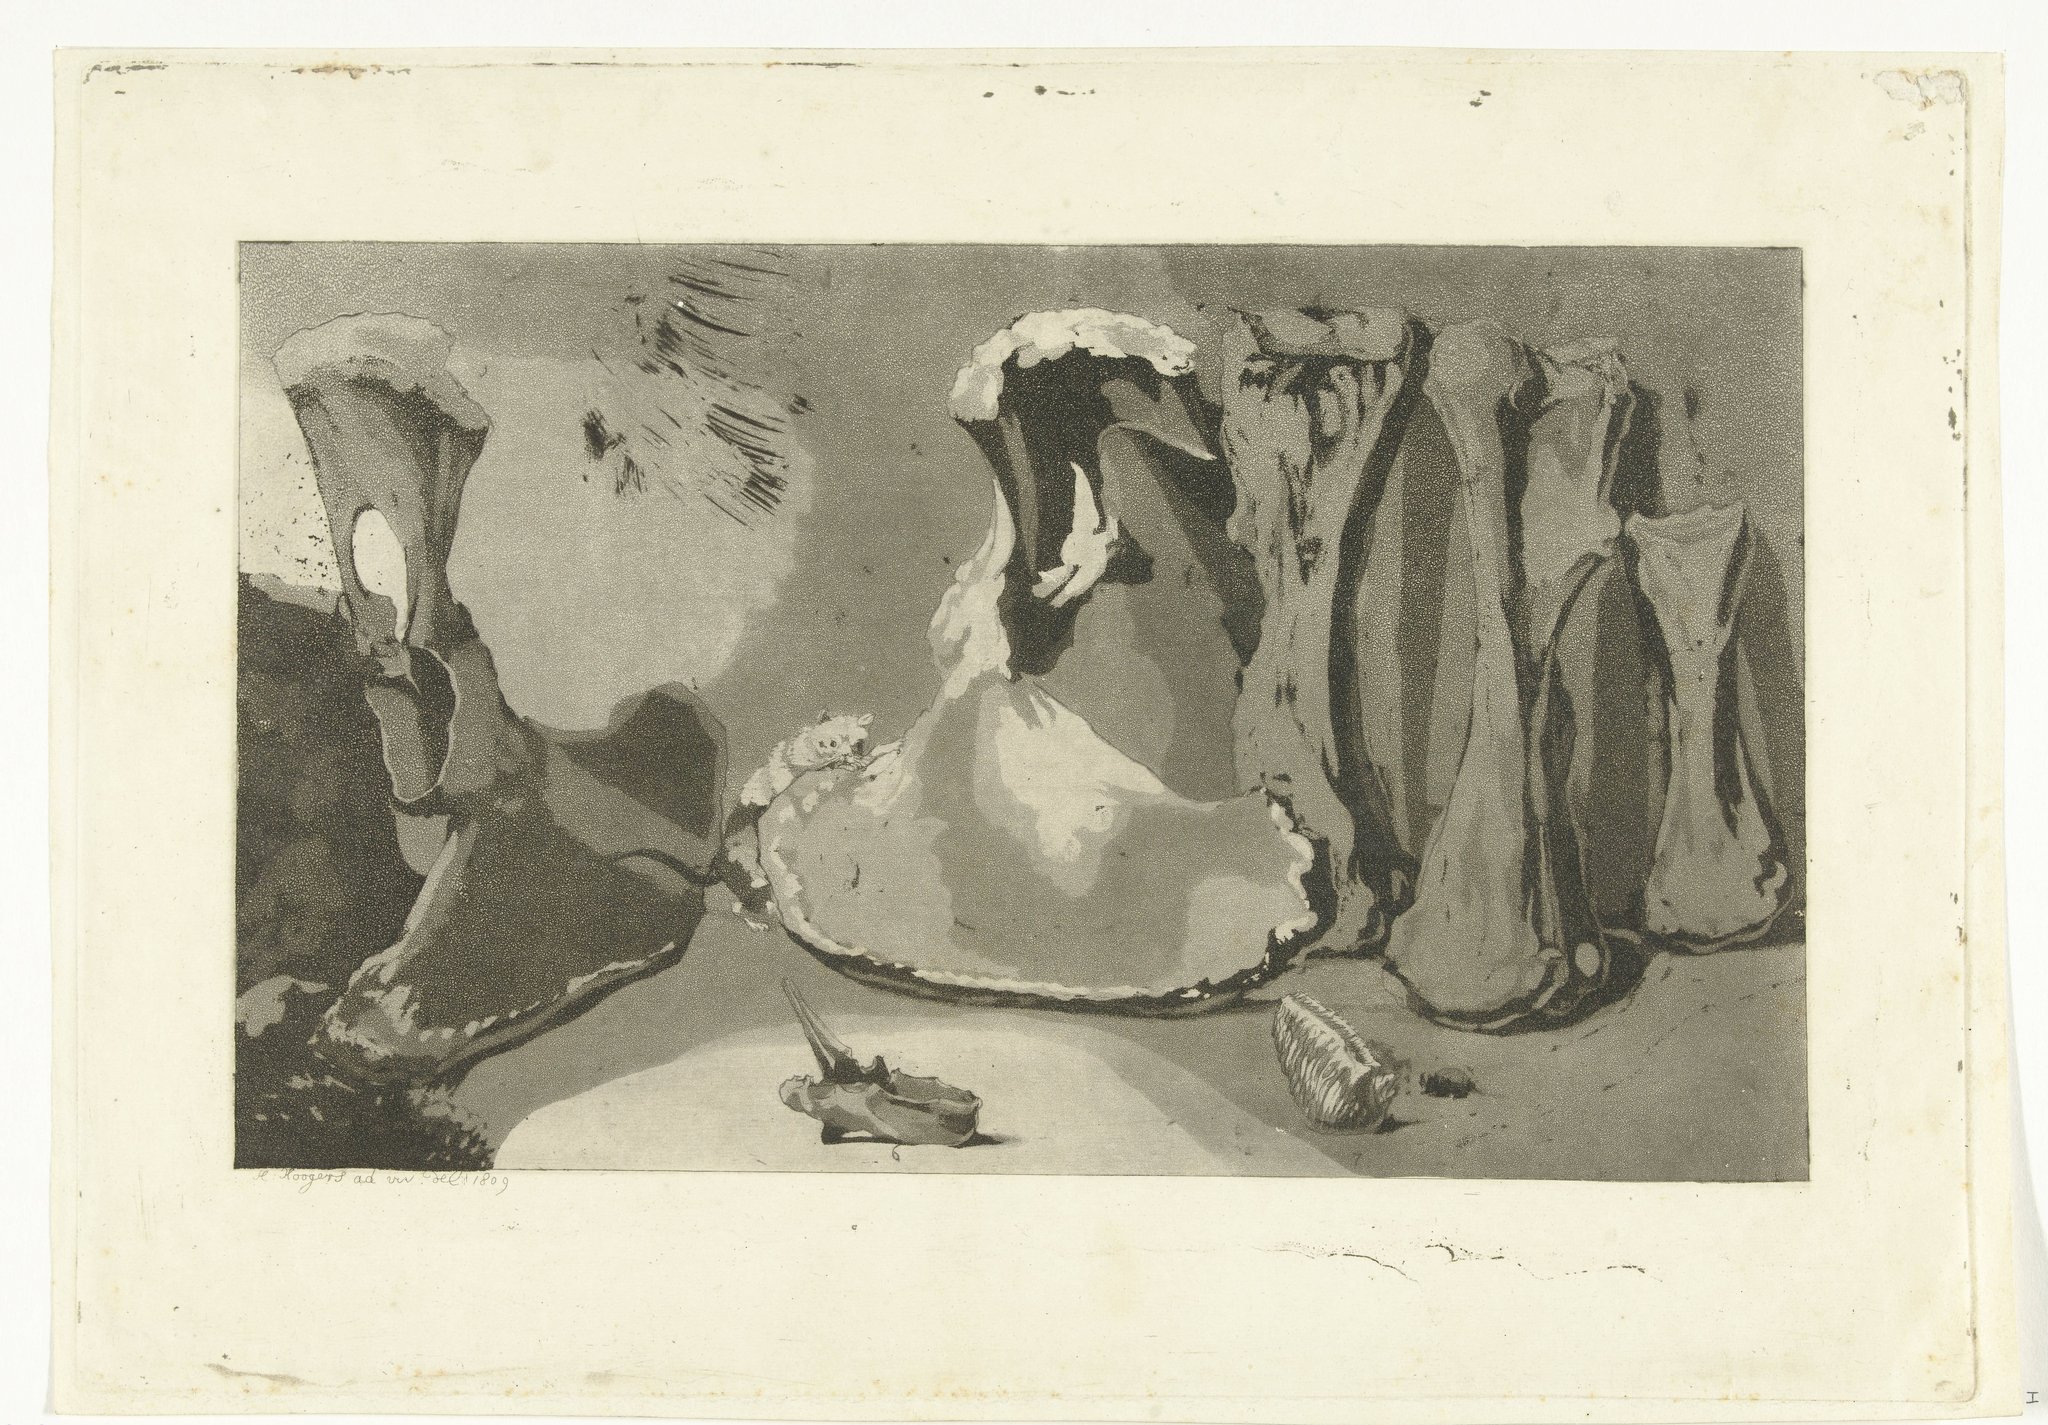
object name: print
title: Eenige beenderen by het doorbreken van den dyk by Loenen, door het water opgeworpen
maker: anthonie van den bos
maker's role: draughtsman, print maker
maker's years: 1763-1838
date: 1809-1810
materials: paper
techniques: aquatint, etching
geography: netherlands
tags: bones in general (human body), gelderland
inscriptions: collector's mark: Lugt 2228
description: Plaat gemaakt voor: H. Ewijk, Platen en kaarten behorende tot het geschiedkundig verslag der dijkbreuken en overstroomingen, langs de rivieren in het Koningrijk Holland, voorgevallen in louwmaand MDCCCIX. Amsterdam, J. Allart en J. Ruys, 1809.